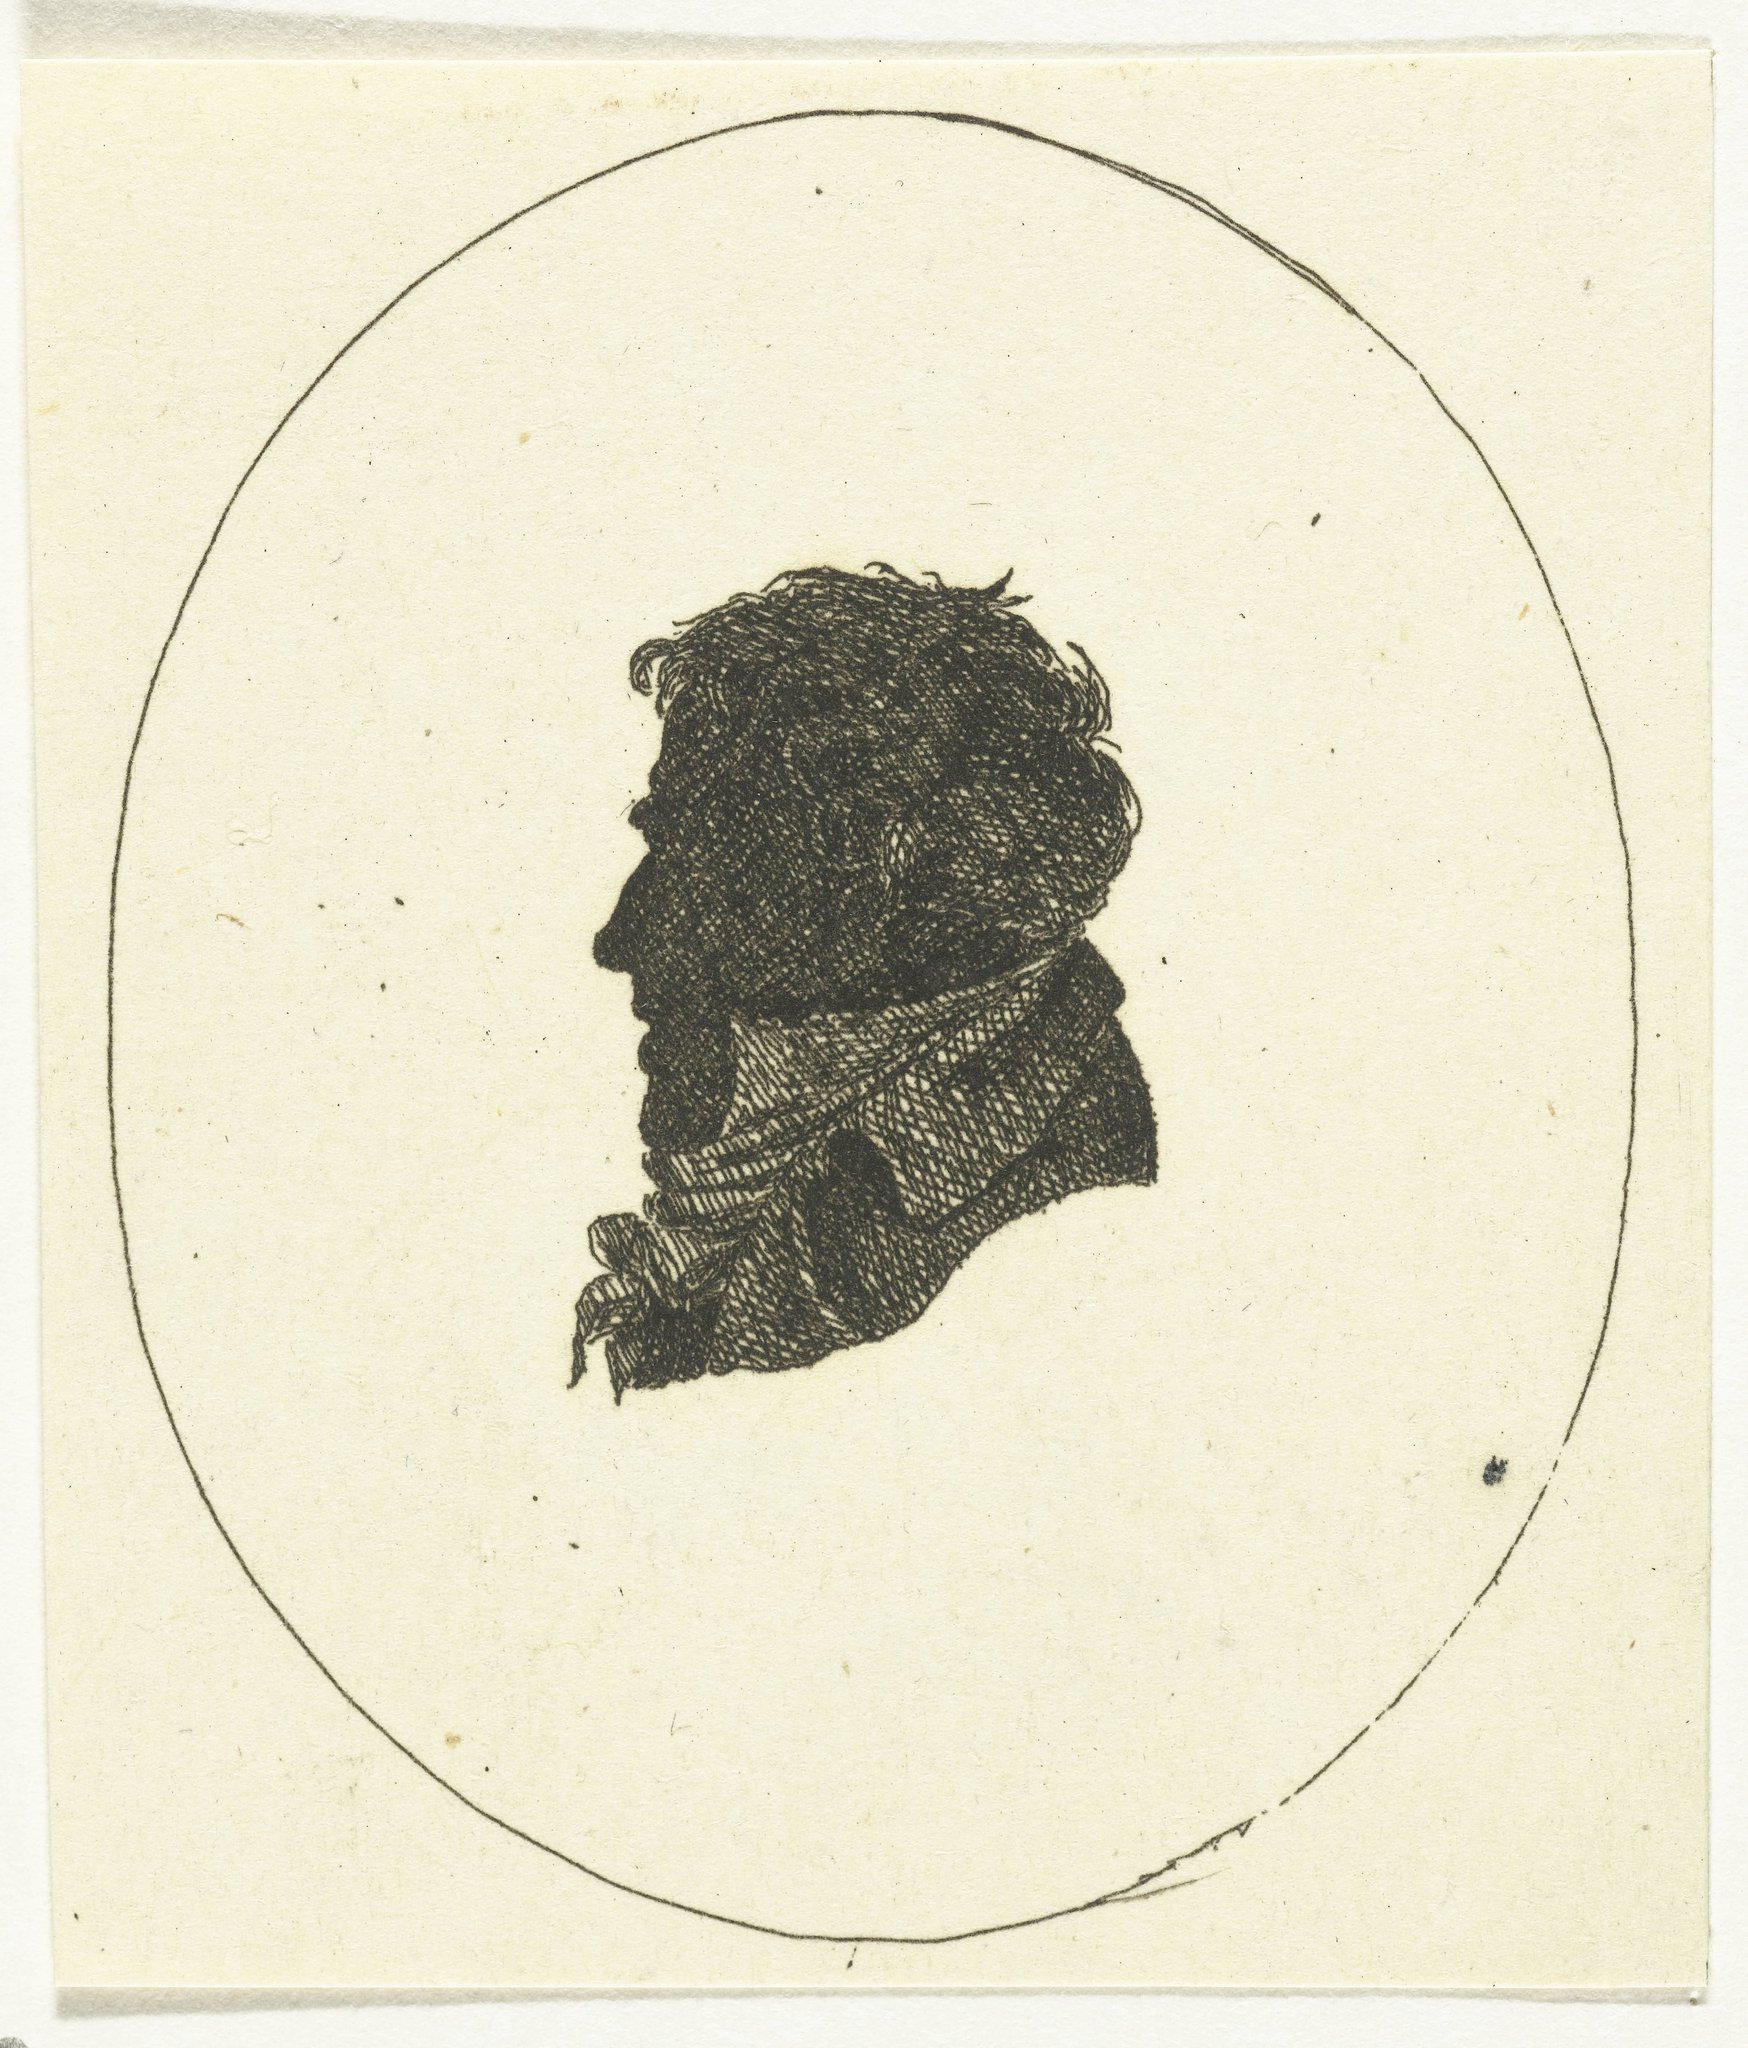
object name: print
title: Silhouetportret van man naar links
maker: anthonie van den bos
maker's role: draughtsman, print maker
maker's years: 1763-1838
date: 1778-1838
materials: paper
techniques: etching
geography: netherlands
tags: anonymous historical person portrayed alone (+ profile portrait)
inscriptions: collector's mark: Lugt 2228